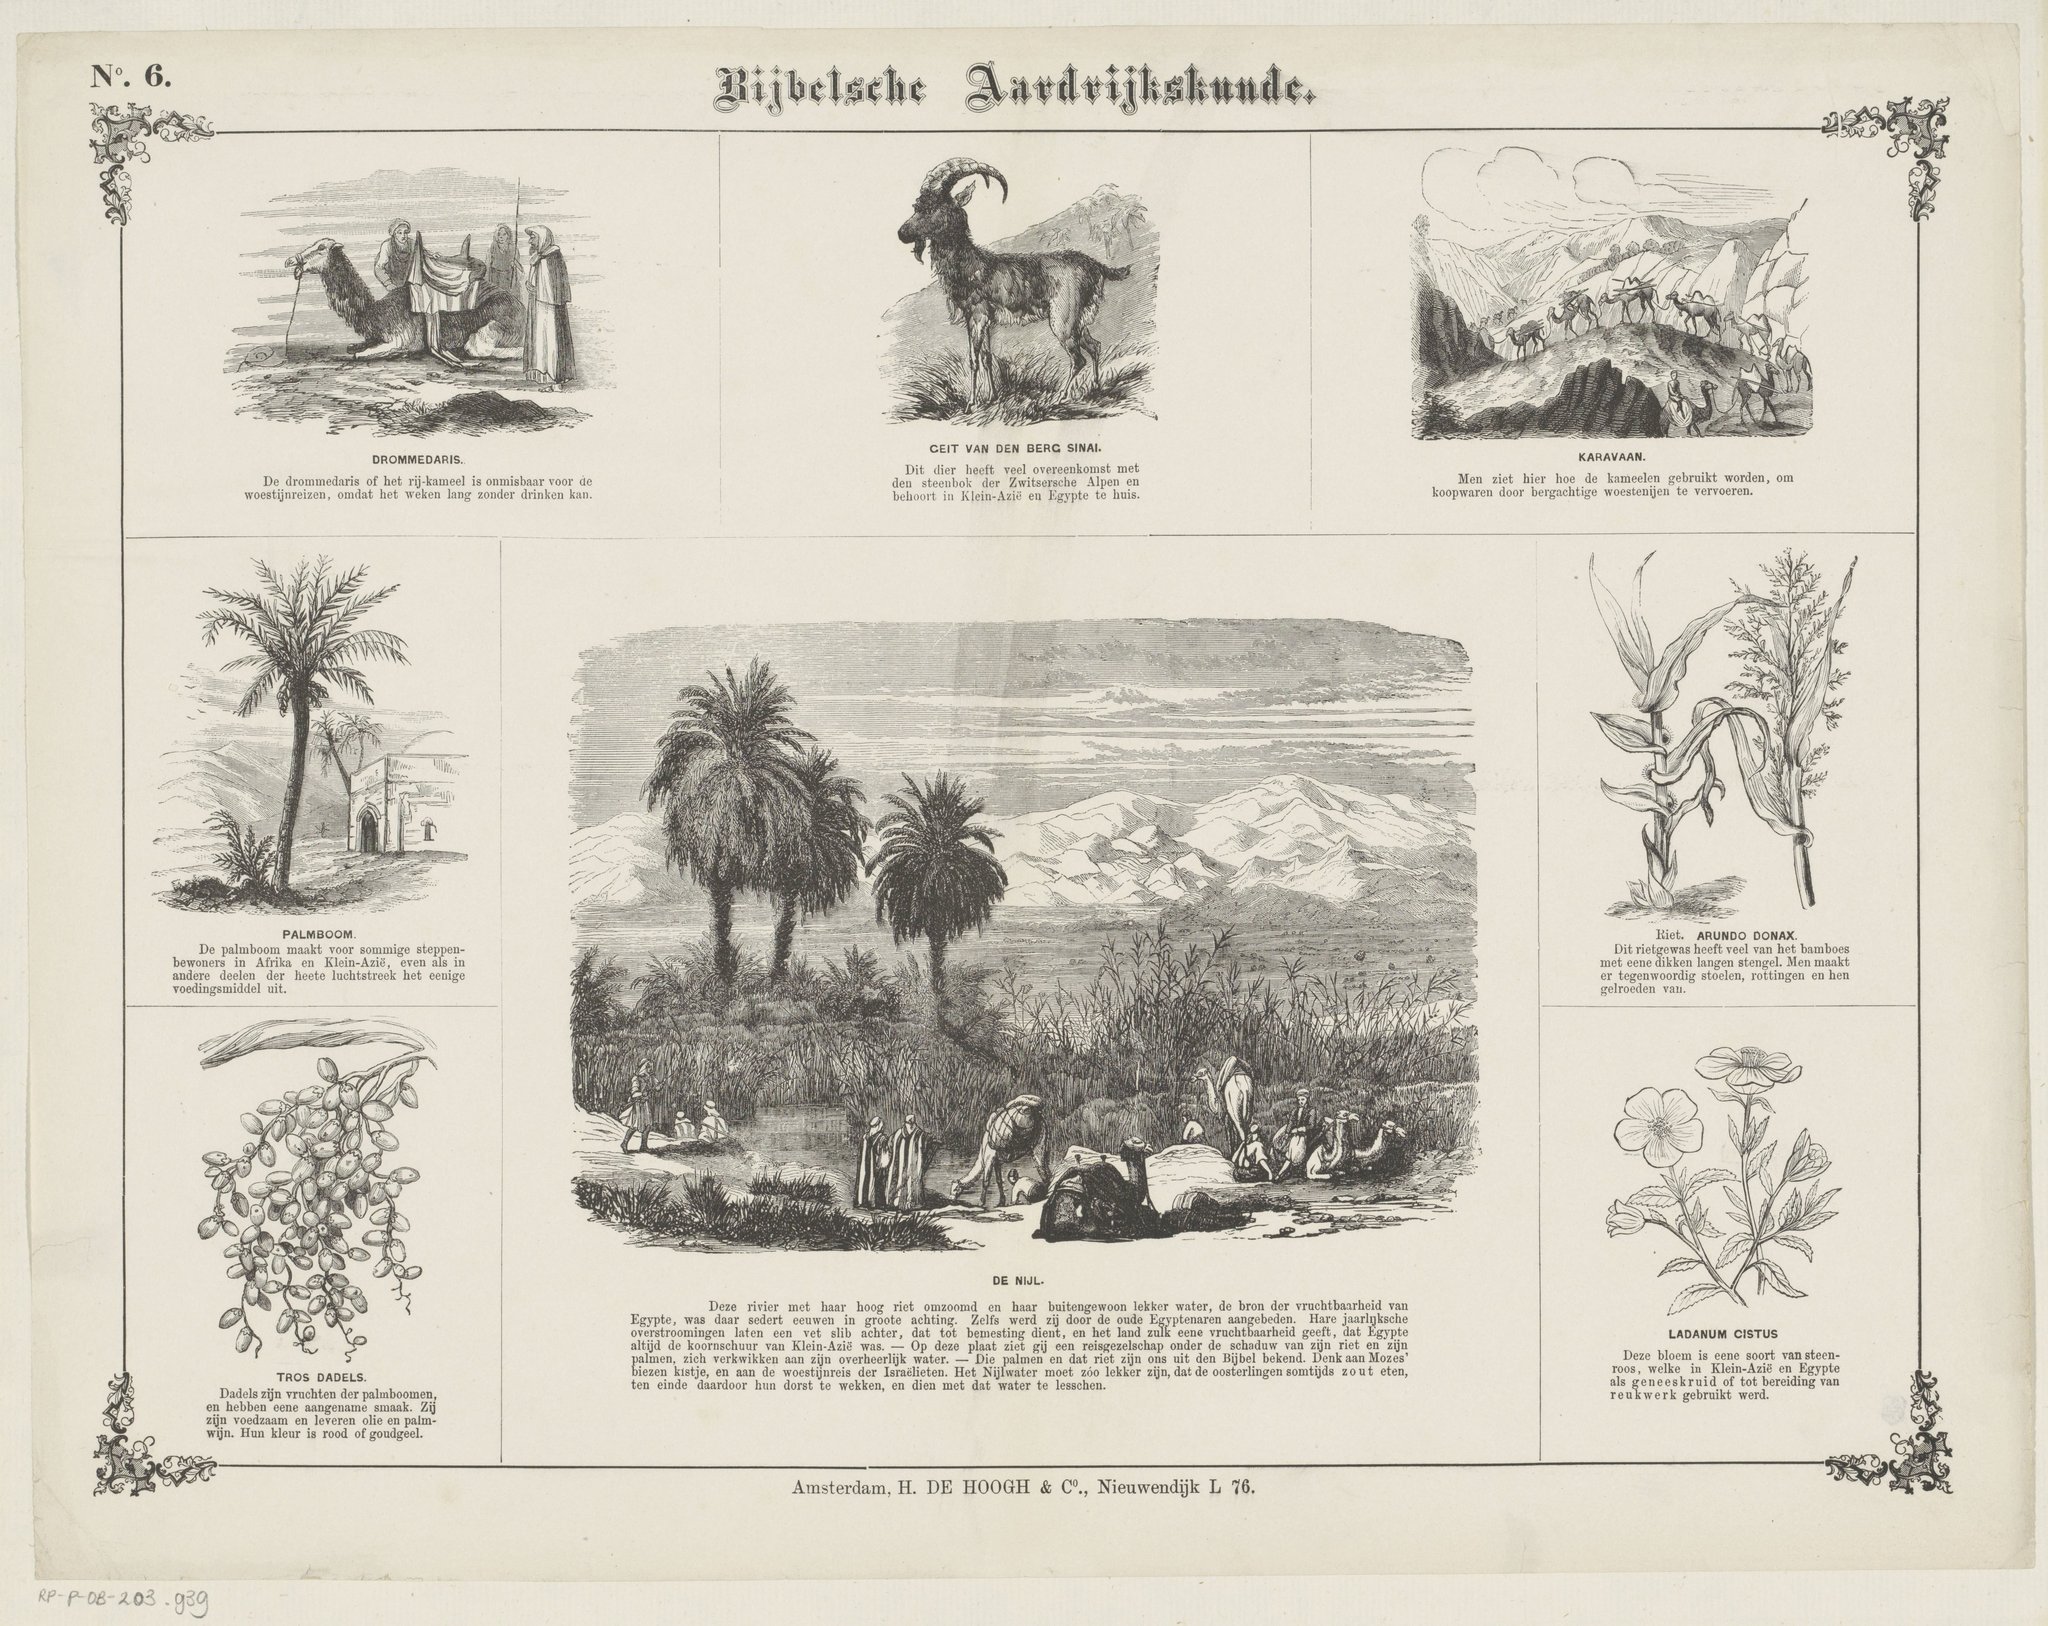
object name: popular print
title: Bijbelsche aardrijkskunde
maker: Anonymous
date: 1866-1871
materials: paper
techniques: letterpress printing, engraving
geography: amsterdam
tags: plants; vegetation, hoofed animals: dromedary, trees: palm-tree, goat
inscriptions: collector's mark: Lugt 2760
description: Blad met 8 voorstellingen van dieren, planten en de Nijl. Onder elke afbeelding een onderschrift. Genummerd linksboven: No. 6.